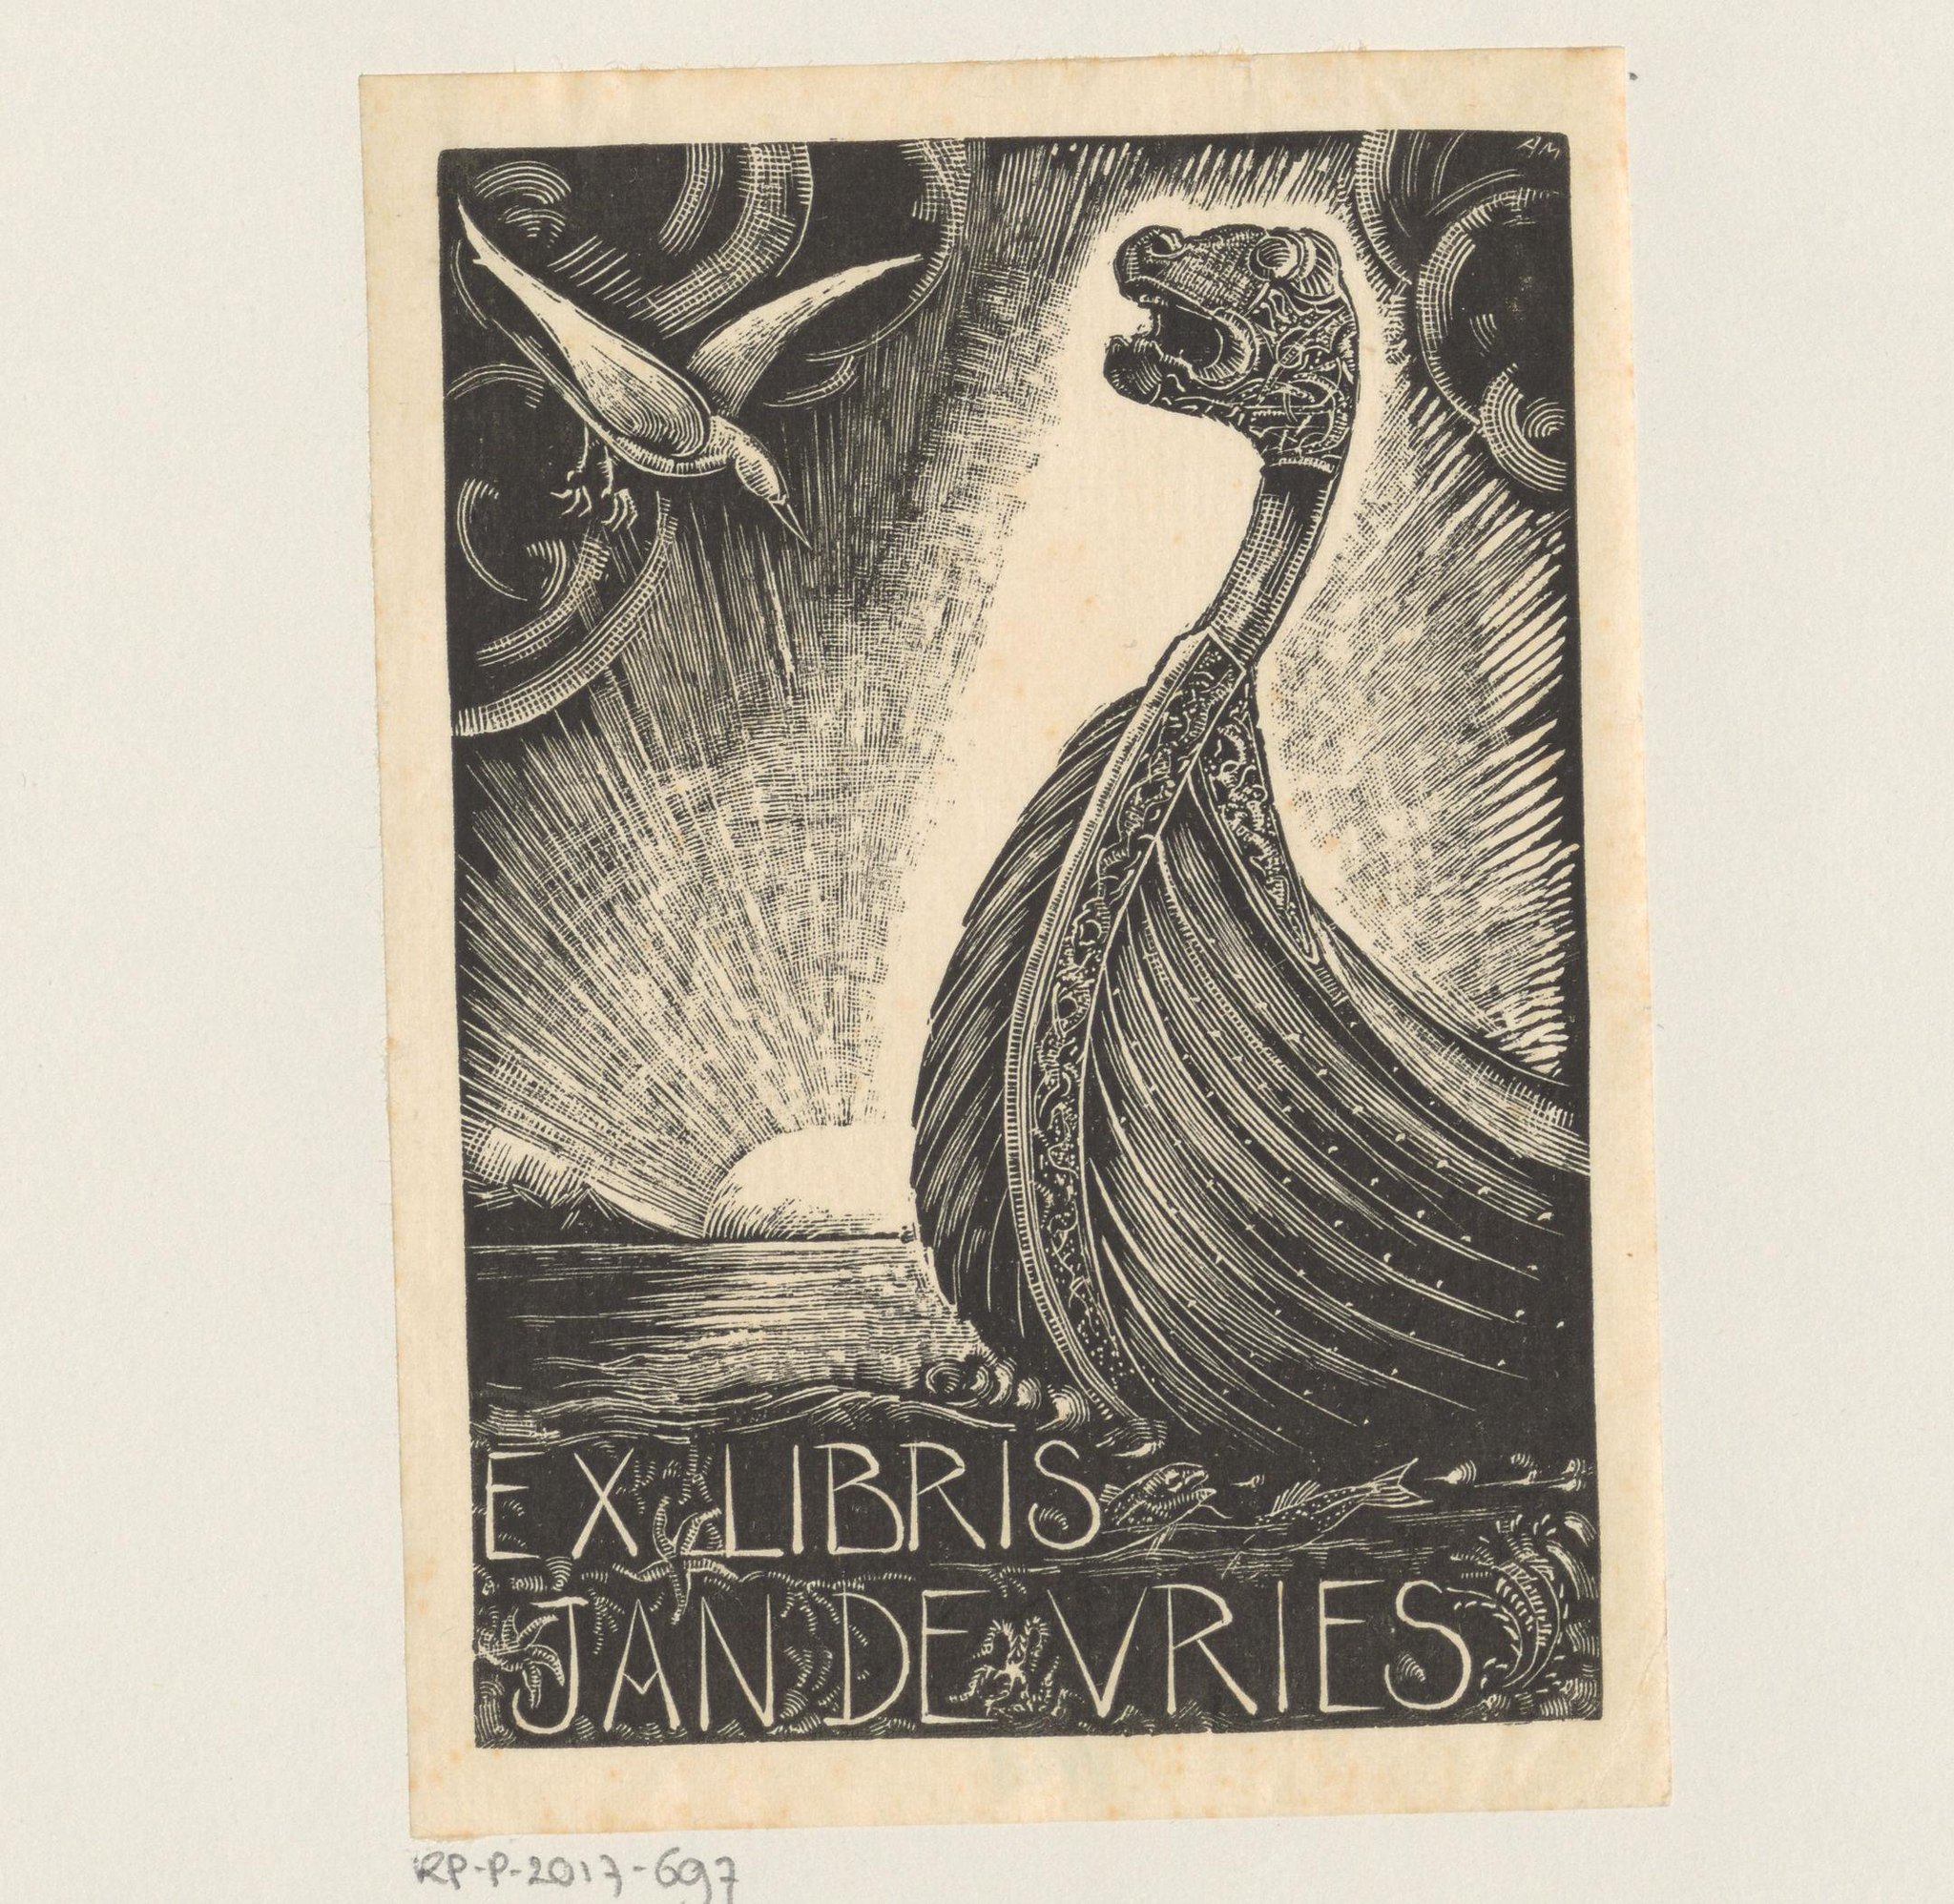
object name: bookplate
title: Ex libris van Jan de Vries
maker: agta meijer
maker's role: painter, print maker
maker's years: 1908-1944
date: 1934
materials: paper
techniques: engraving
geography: netherlands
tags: ships (in general), shore-birds and wading-birds: gull, parts of ship's exterior: figure-head